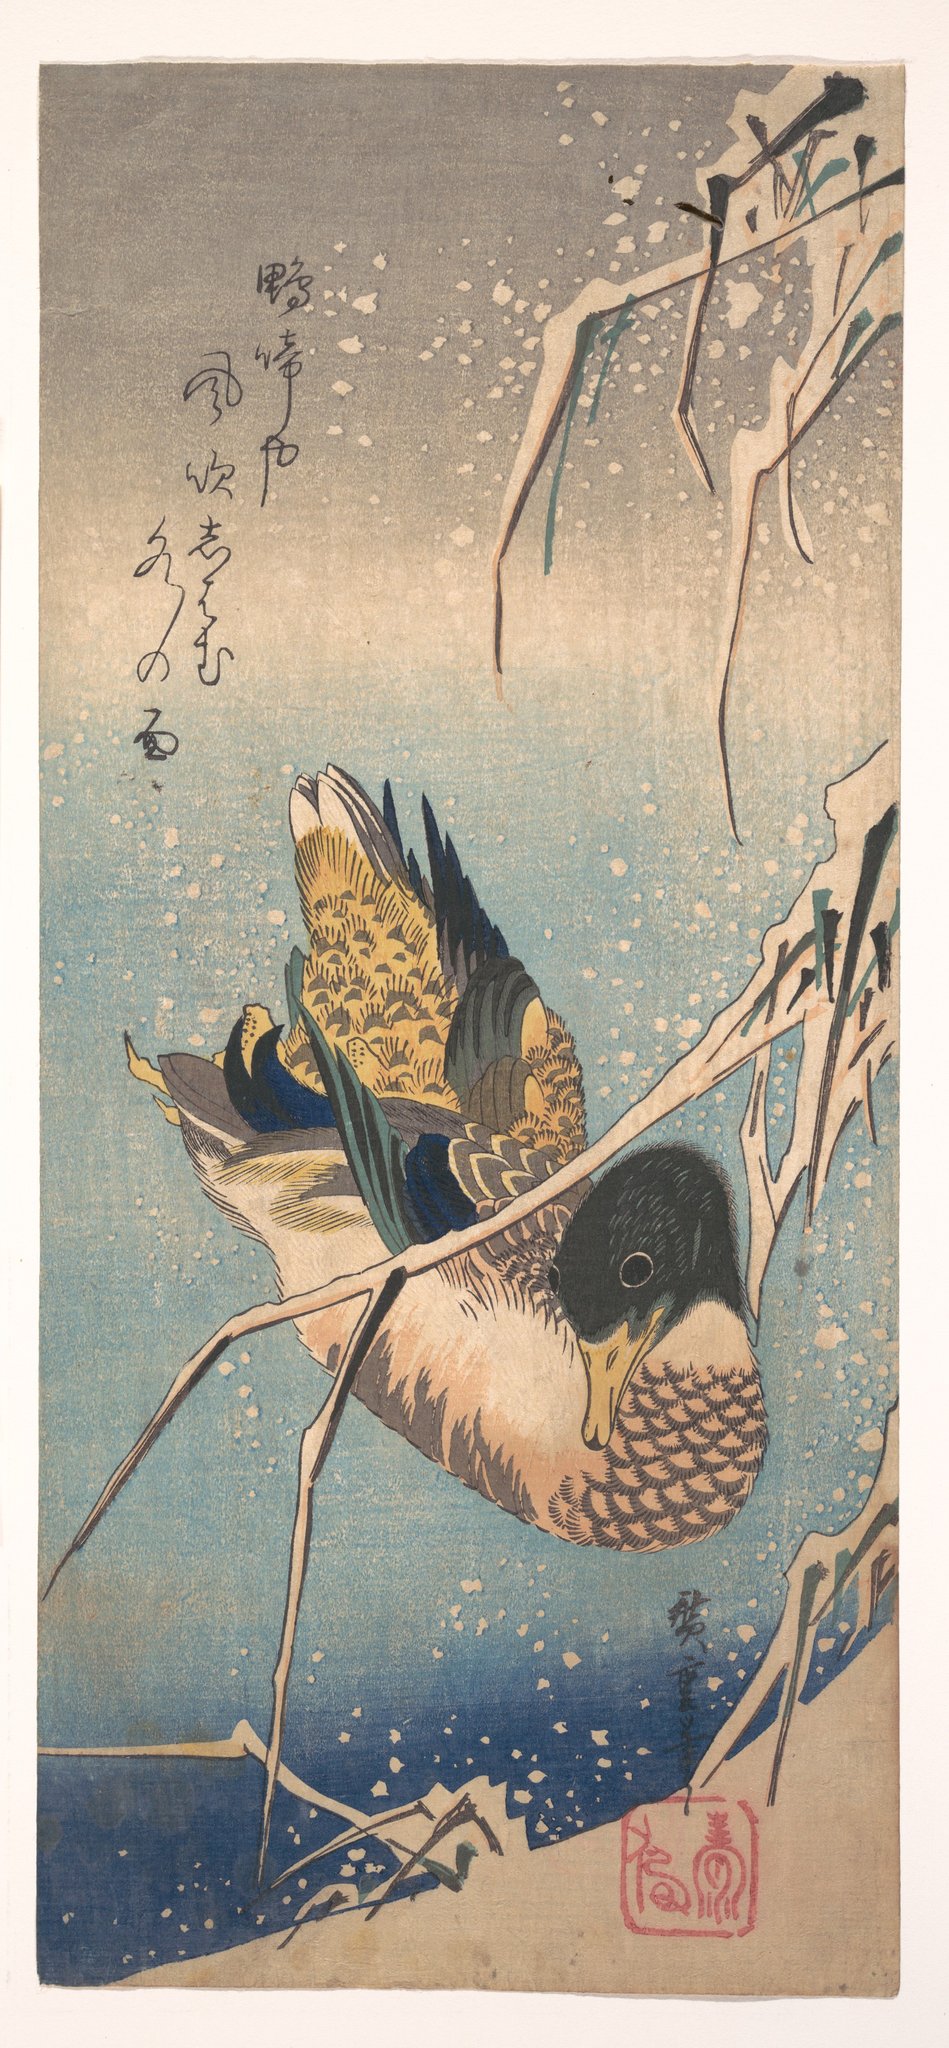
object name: woodblock print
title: A Wild Duck near a Snow-laden Shore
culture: japanese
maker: utagawa hiroshige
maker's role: artist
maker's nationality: japanese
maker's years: 1797-1858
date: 1843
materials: ink, paper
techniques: woodblock print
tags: ducks